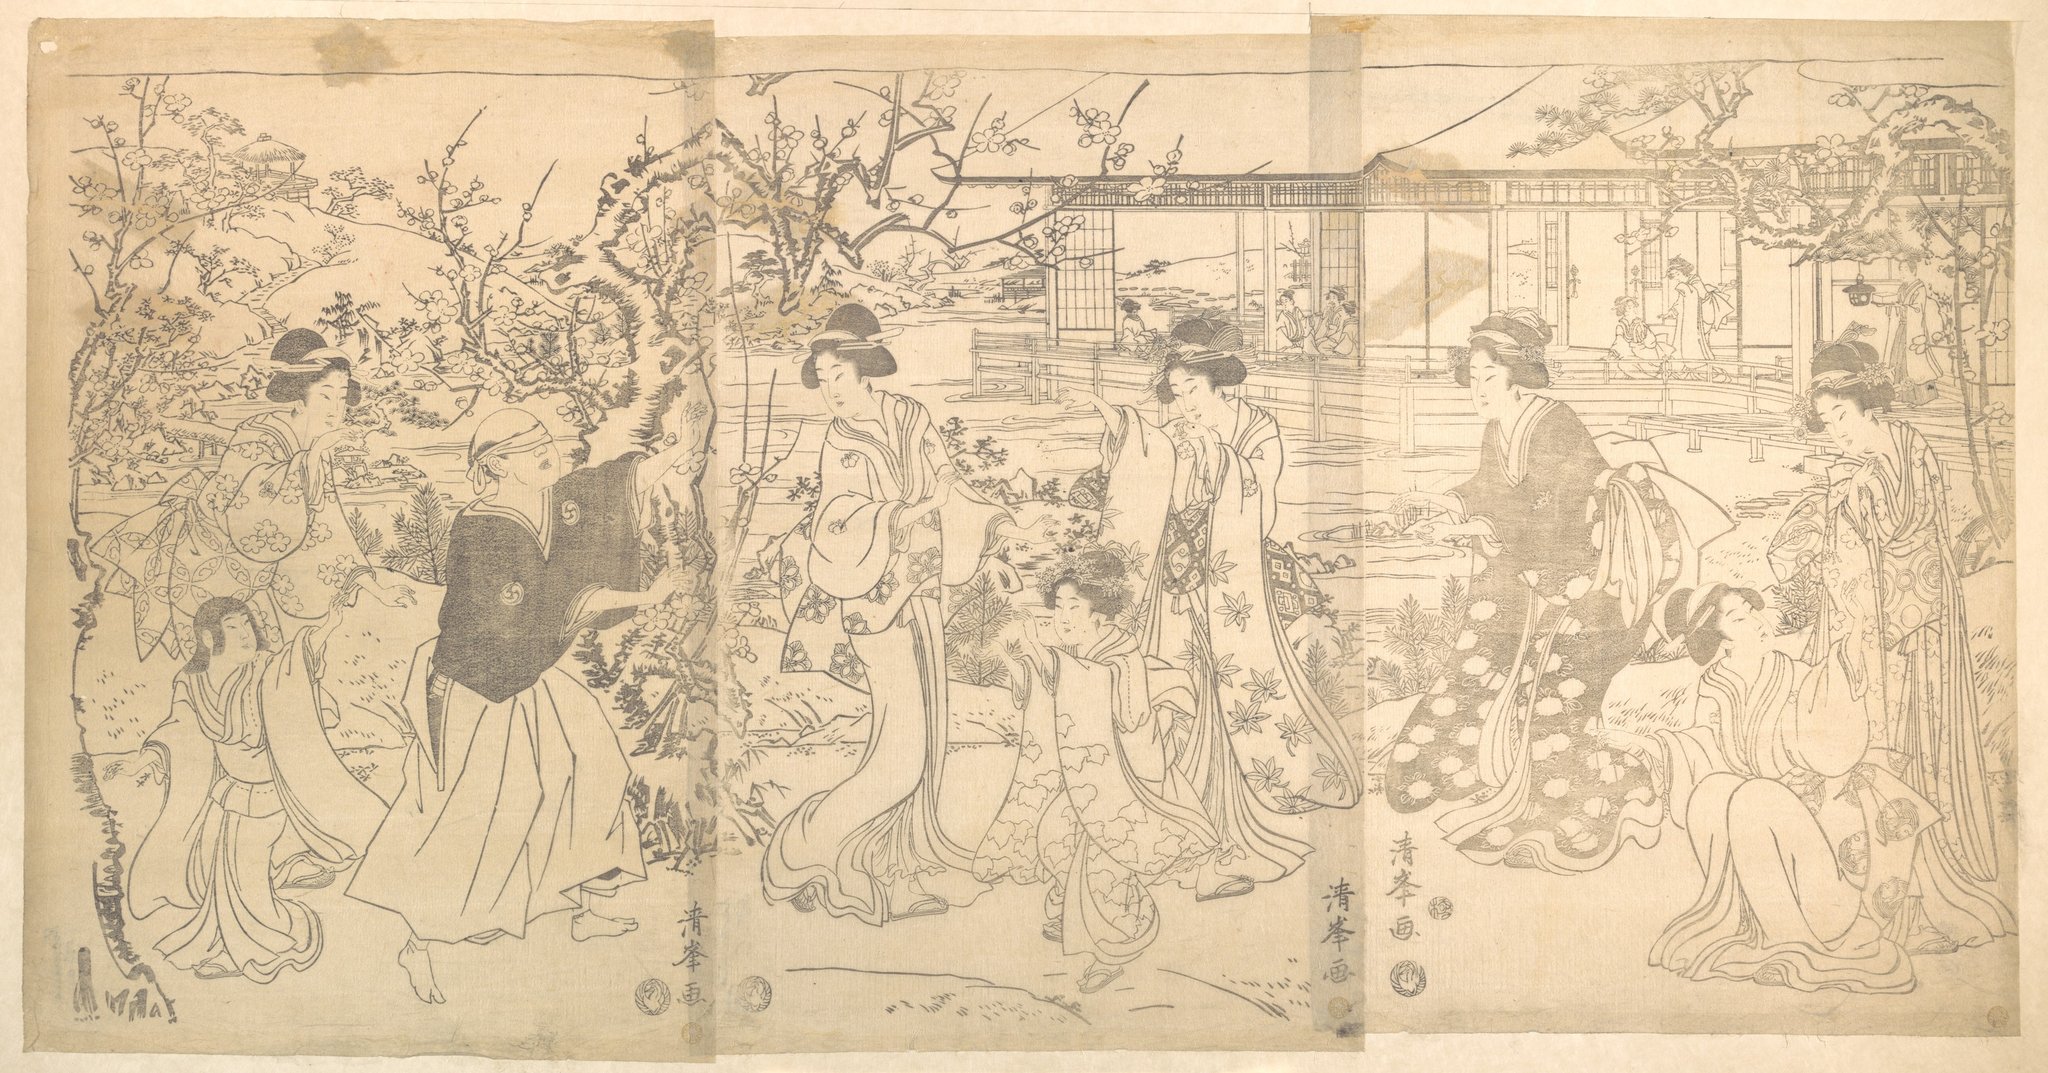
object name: print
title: Scene from the Chushihgura (Vendetta of the 47 Loyal Retailers)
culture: japanese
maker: torii kiyomine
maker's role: artist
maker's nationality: japanese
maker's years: 1787-1868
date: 1820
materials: ink, paper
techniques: woodblock print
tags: men,women,games,tea houses